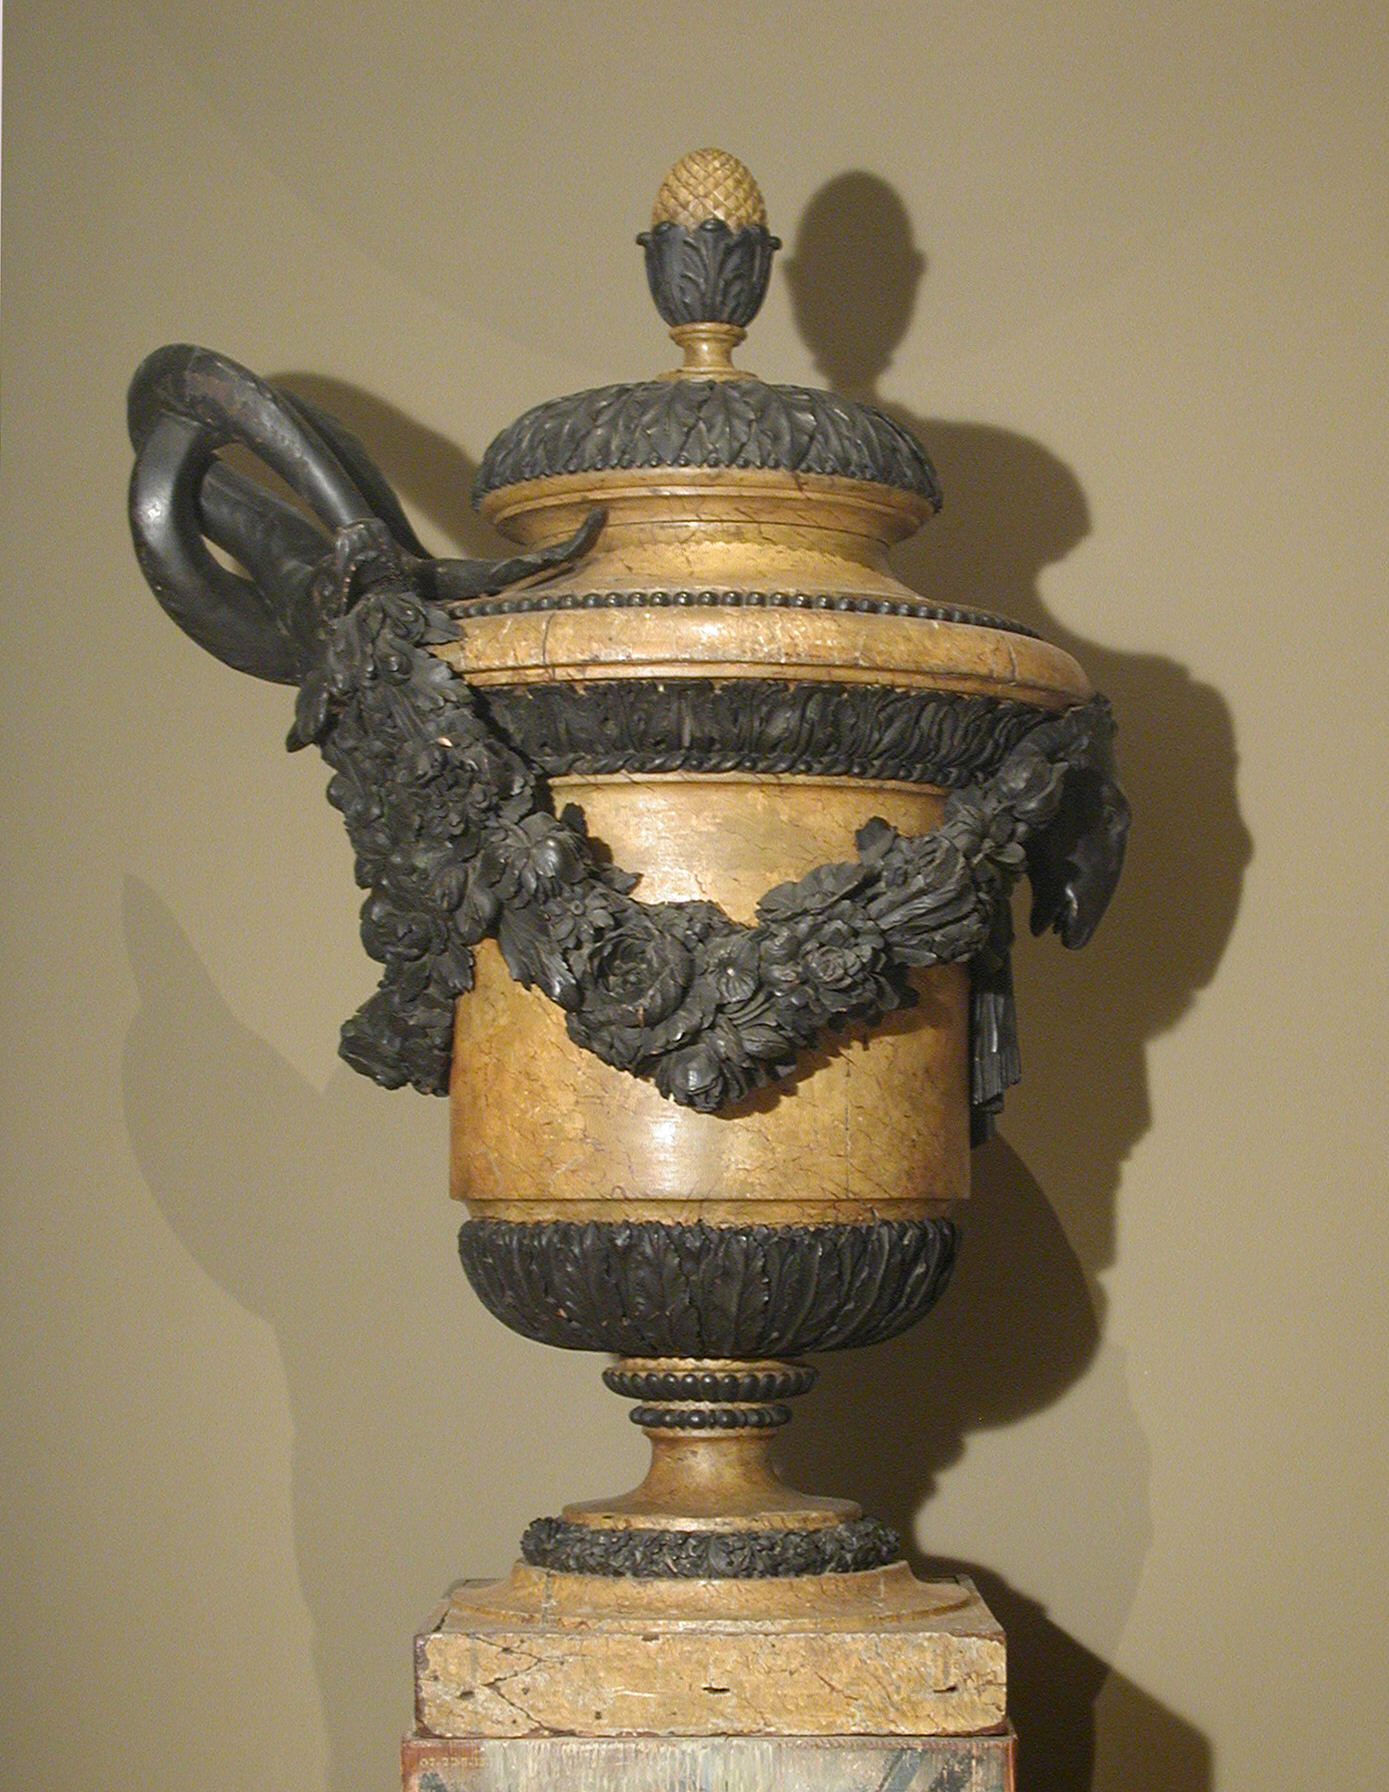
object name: vase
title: Neoclassical vase (one of a pair)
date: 1780-1785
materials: wood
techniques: carving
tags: flowers